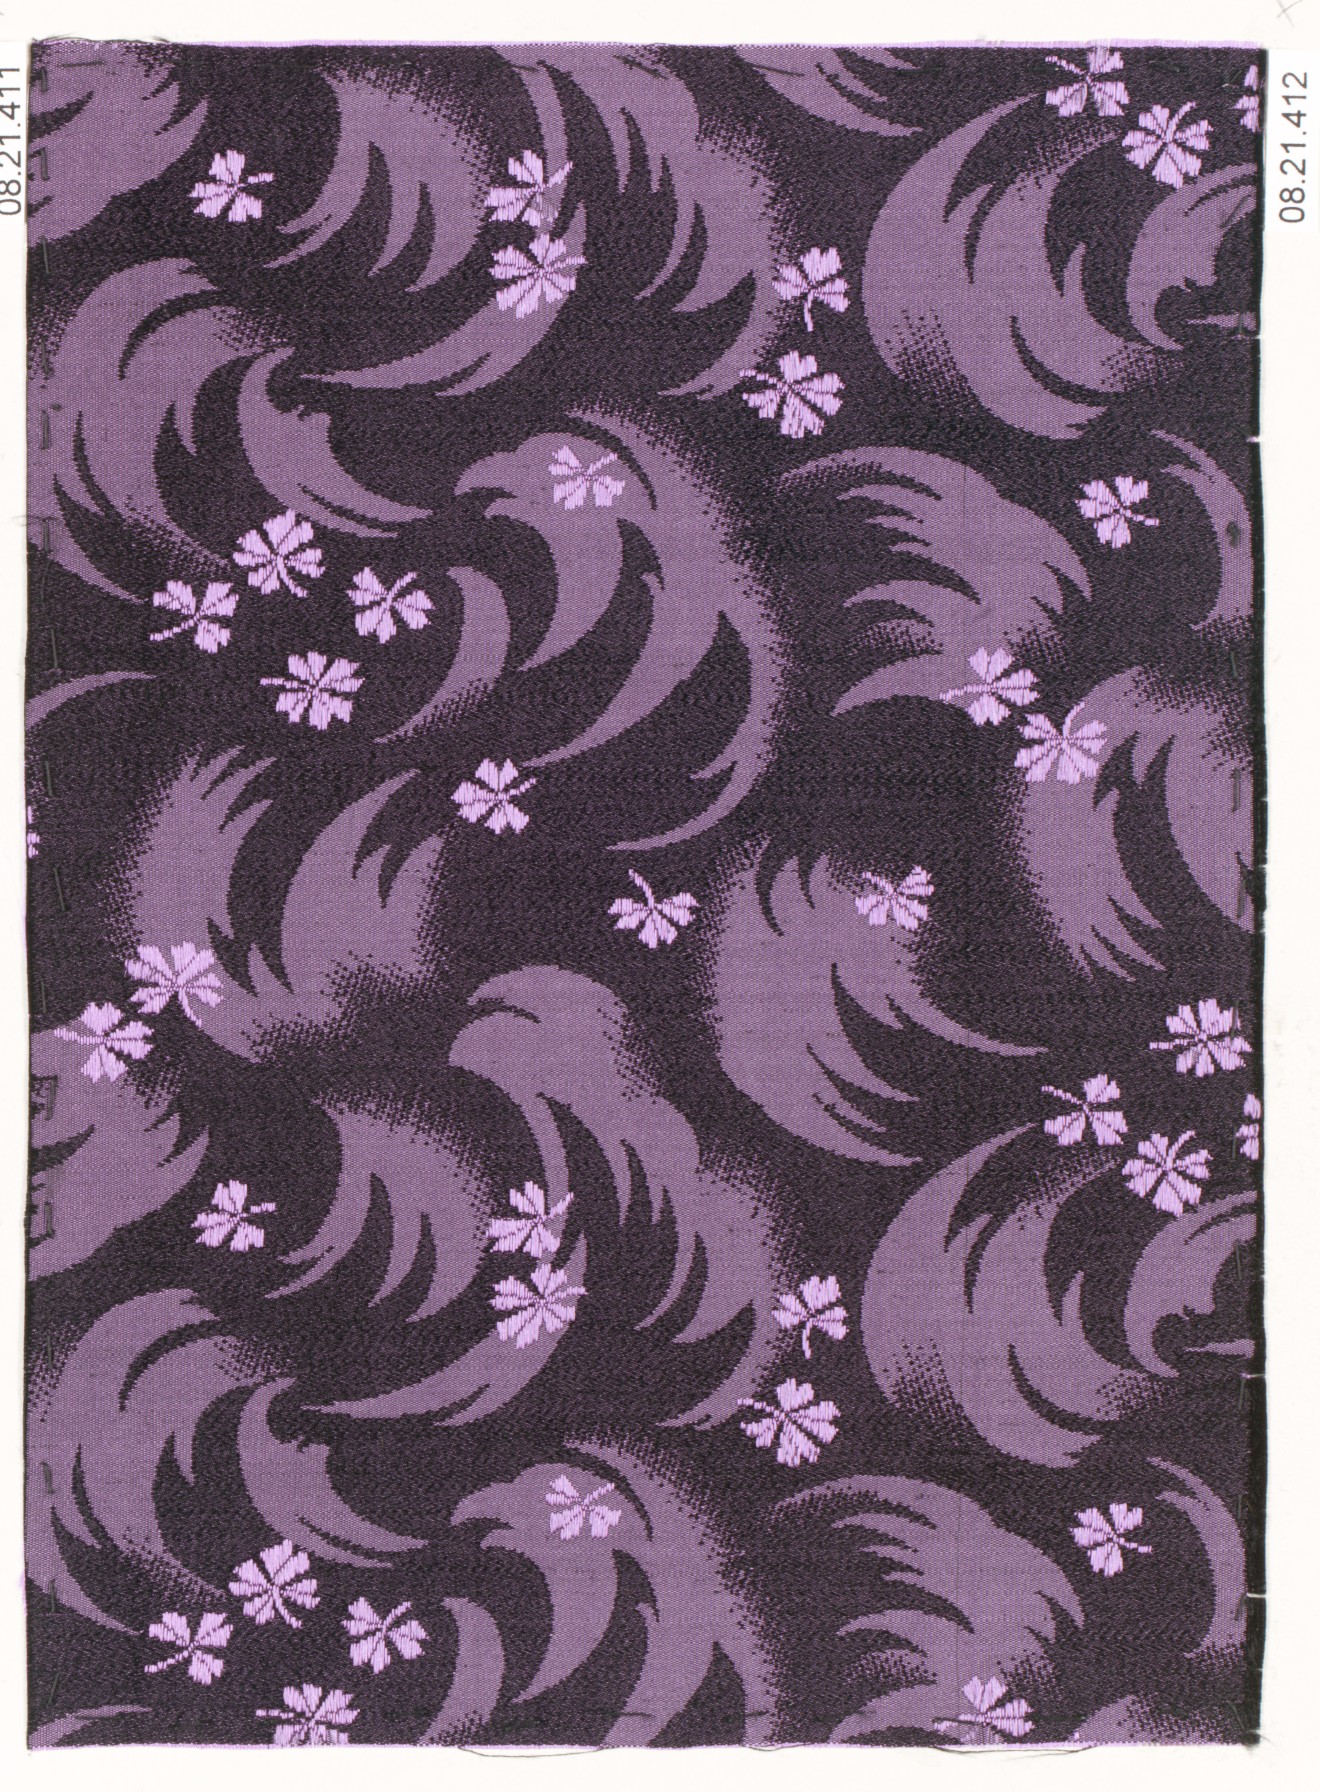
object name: textile sample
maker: Anonymous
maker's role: designer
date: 1900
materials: silk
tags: flowers